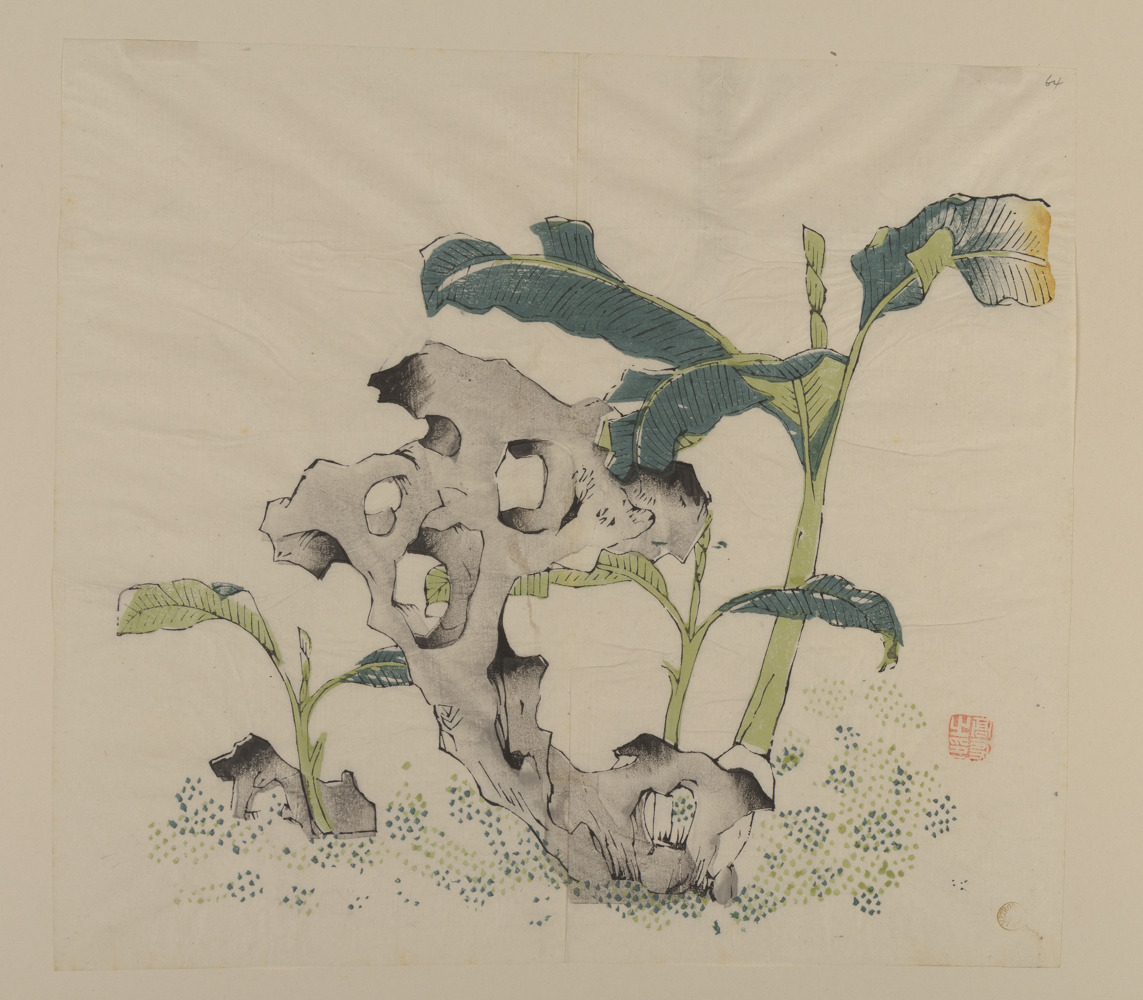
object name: print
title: Page from Shi Zhu Zhai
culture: chinese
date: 1736-1795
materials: ink, paper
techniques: polychrome, woodblock print